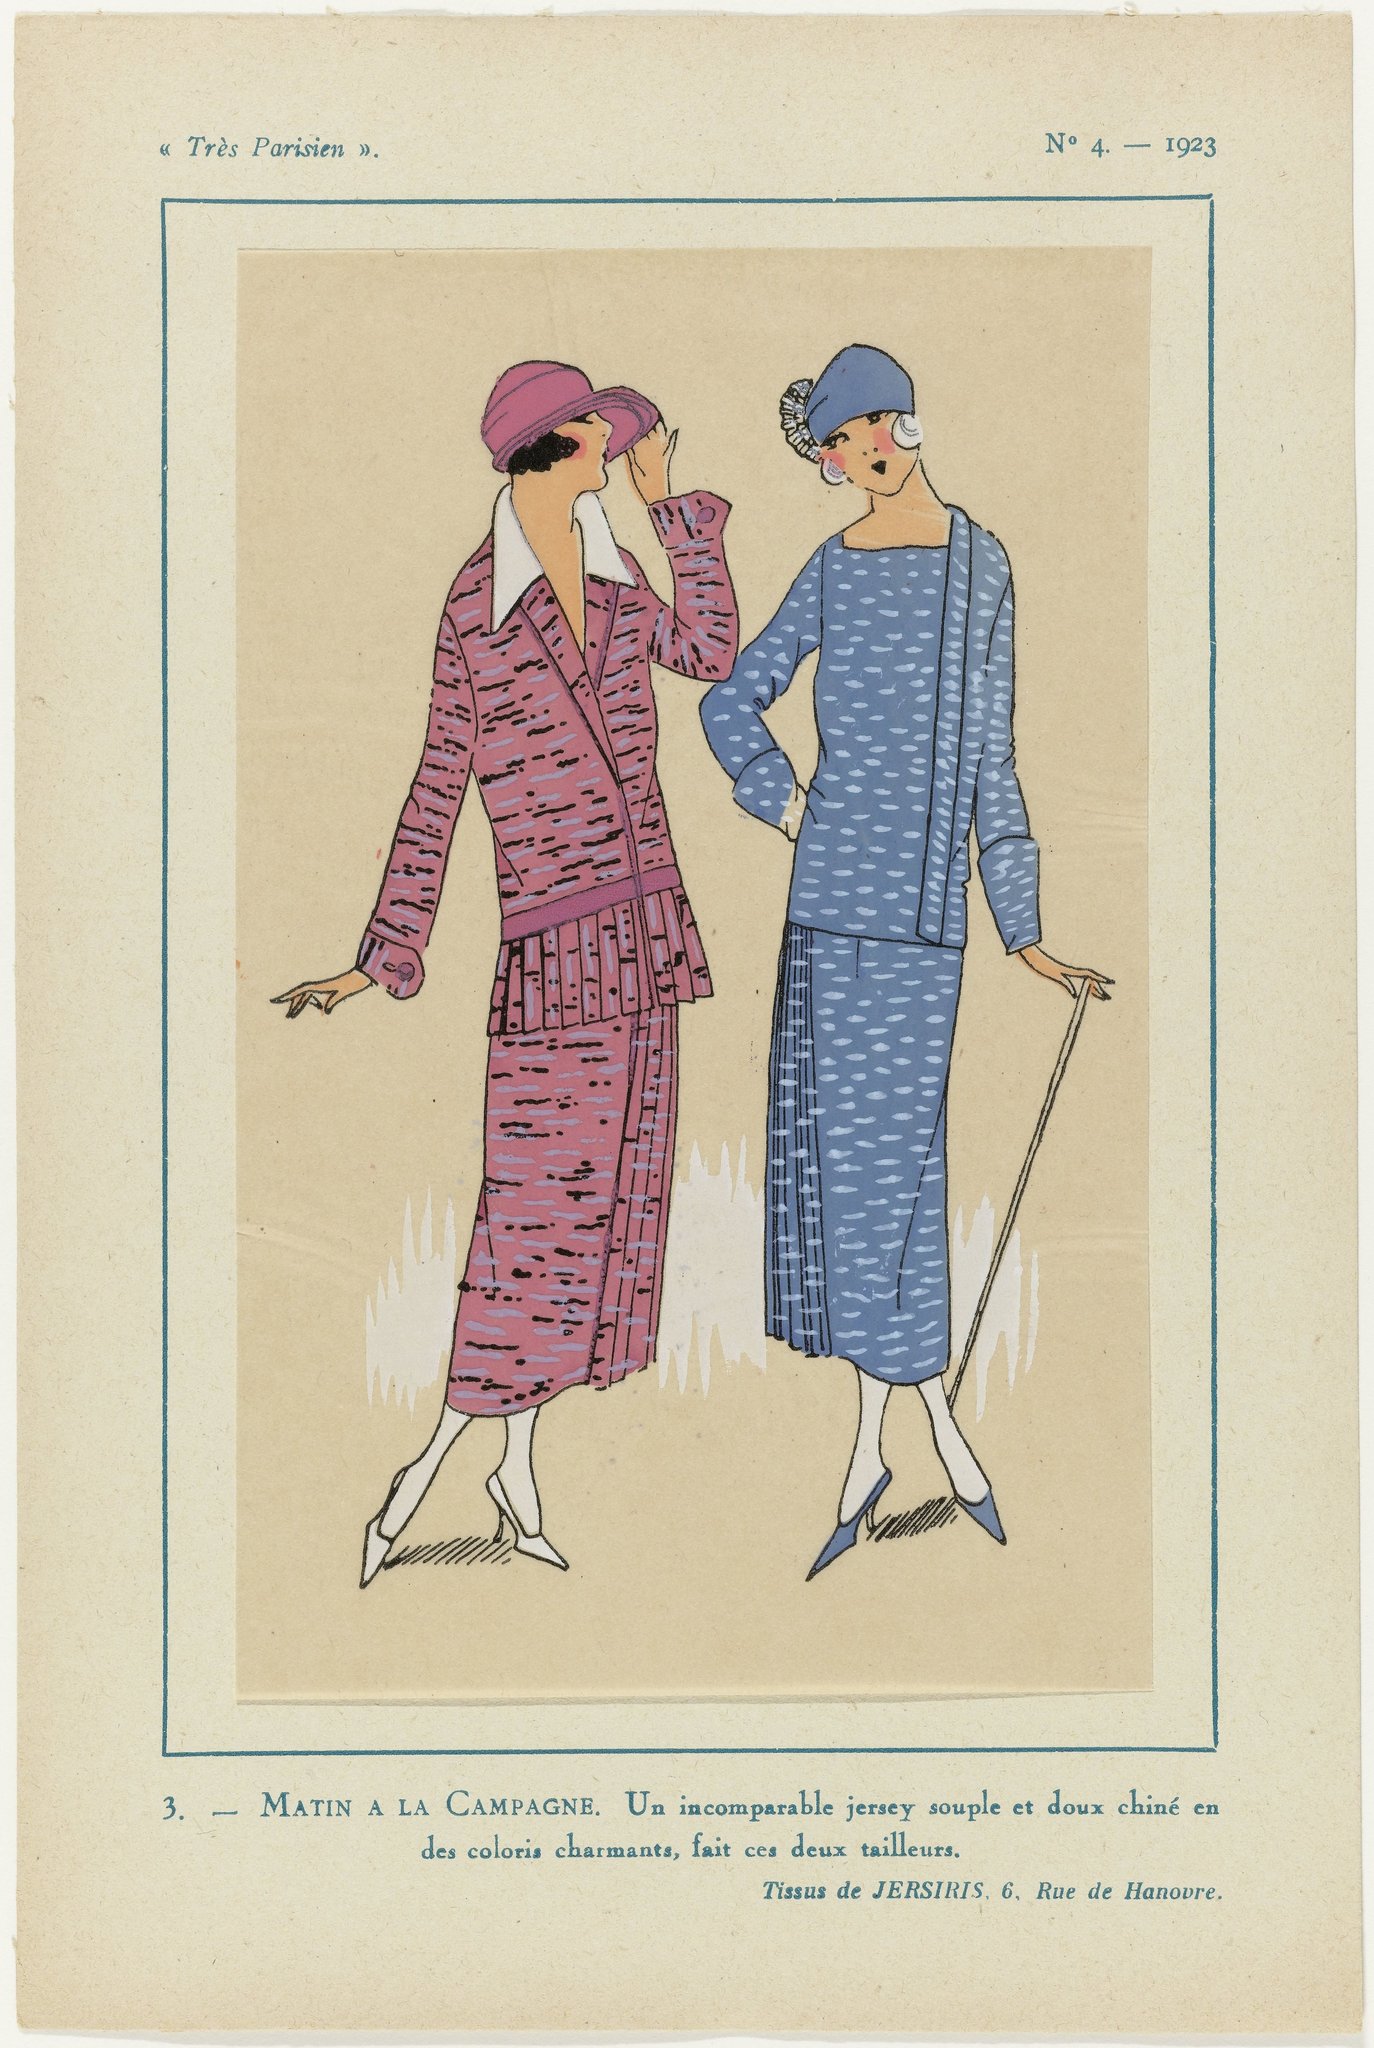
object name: fashion print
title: Très Parisien, 1923, No. 4: 3. - MATIN A LA CAMPAGNE...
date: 1923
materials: paper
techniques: hand coloring, letterpress printing, lithography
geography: paris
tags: clothing for the upper part of the body (+ women's clothes), walking-stick, staff, cane (+ women's clothes), ensembles of pieces of clothing (suit) (+ women's clothes), fashion plates, skirt (+ women's clothes)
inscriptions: caption: ‘3. - MATIN A LA CAMPAGNE. Un incomparable jersey souple et doux chiné en des coloris charmants, fait ces deux tailleurs. / Tissus de JERSIRIS, 6, Rue de Hanovre.’, title: ‘Très Parisien / No 4. - 1923’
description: Stoffen van Jersiris. Twee tailleurs (mantelpakken) gemaakt van een unieke soepele en gespikkelde jersey in charmante kleuren. Prent uit het modetijdschrift Très Parisien (1920-1936).